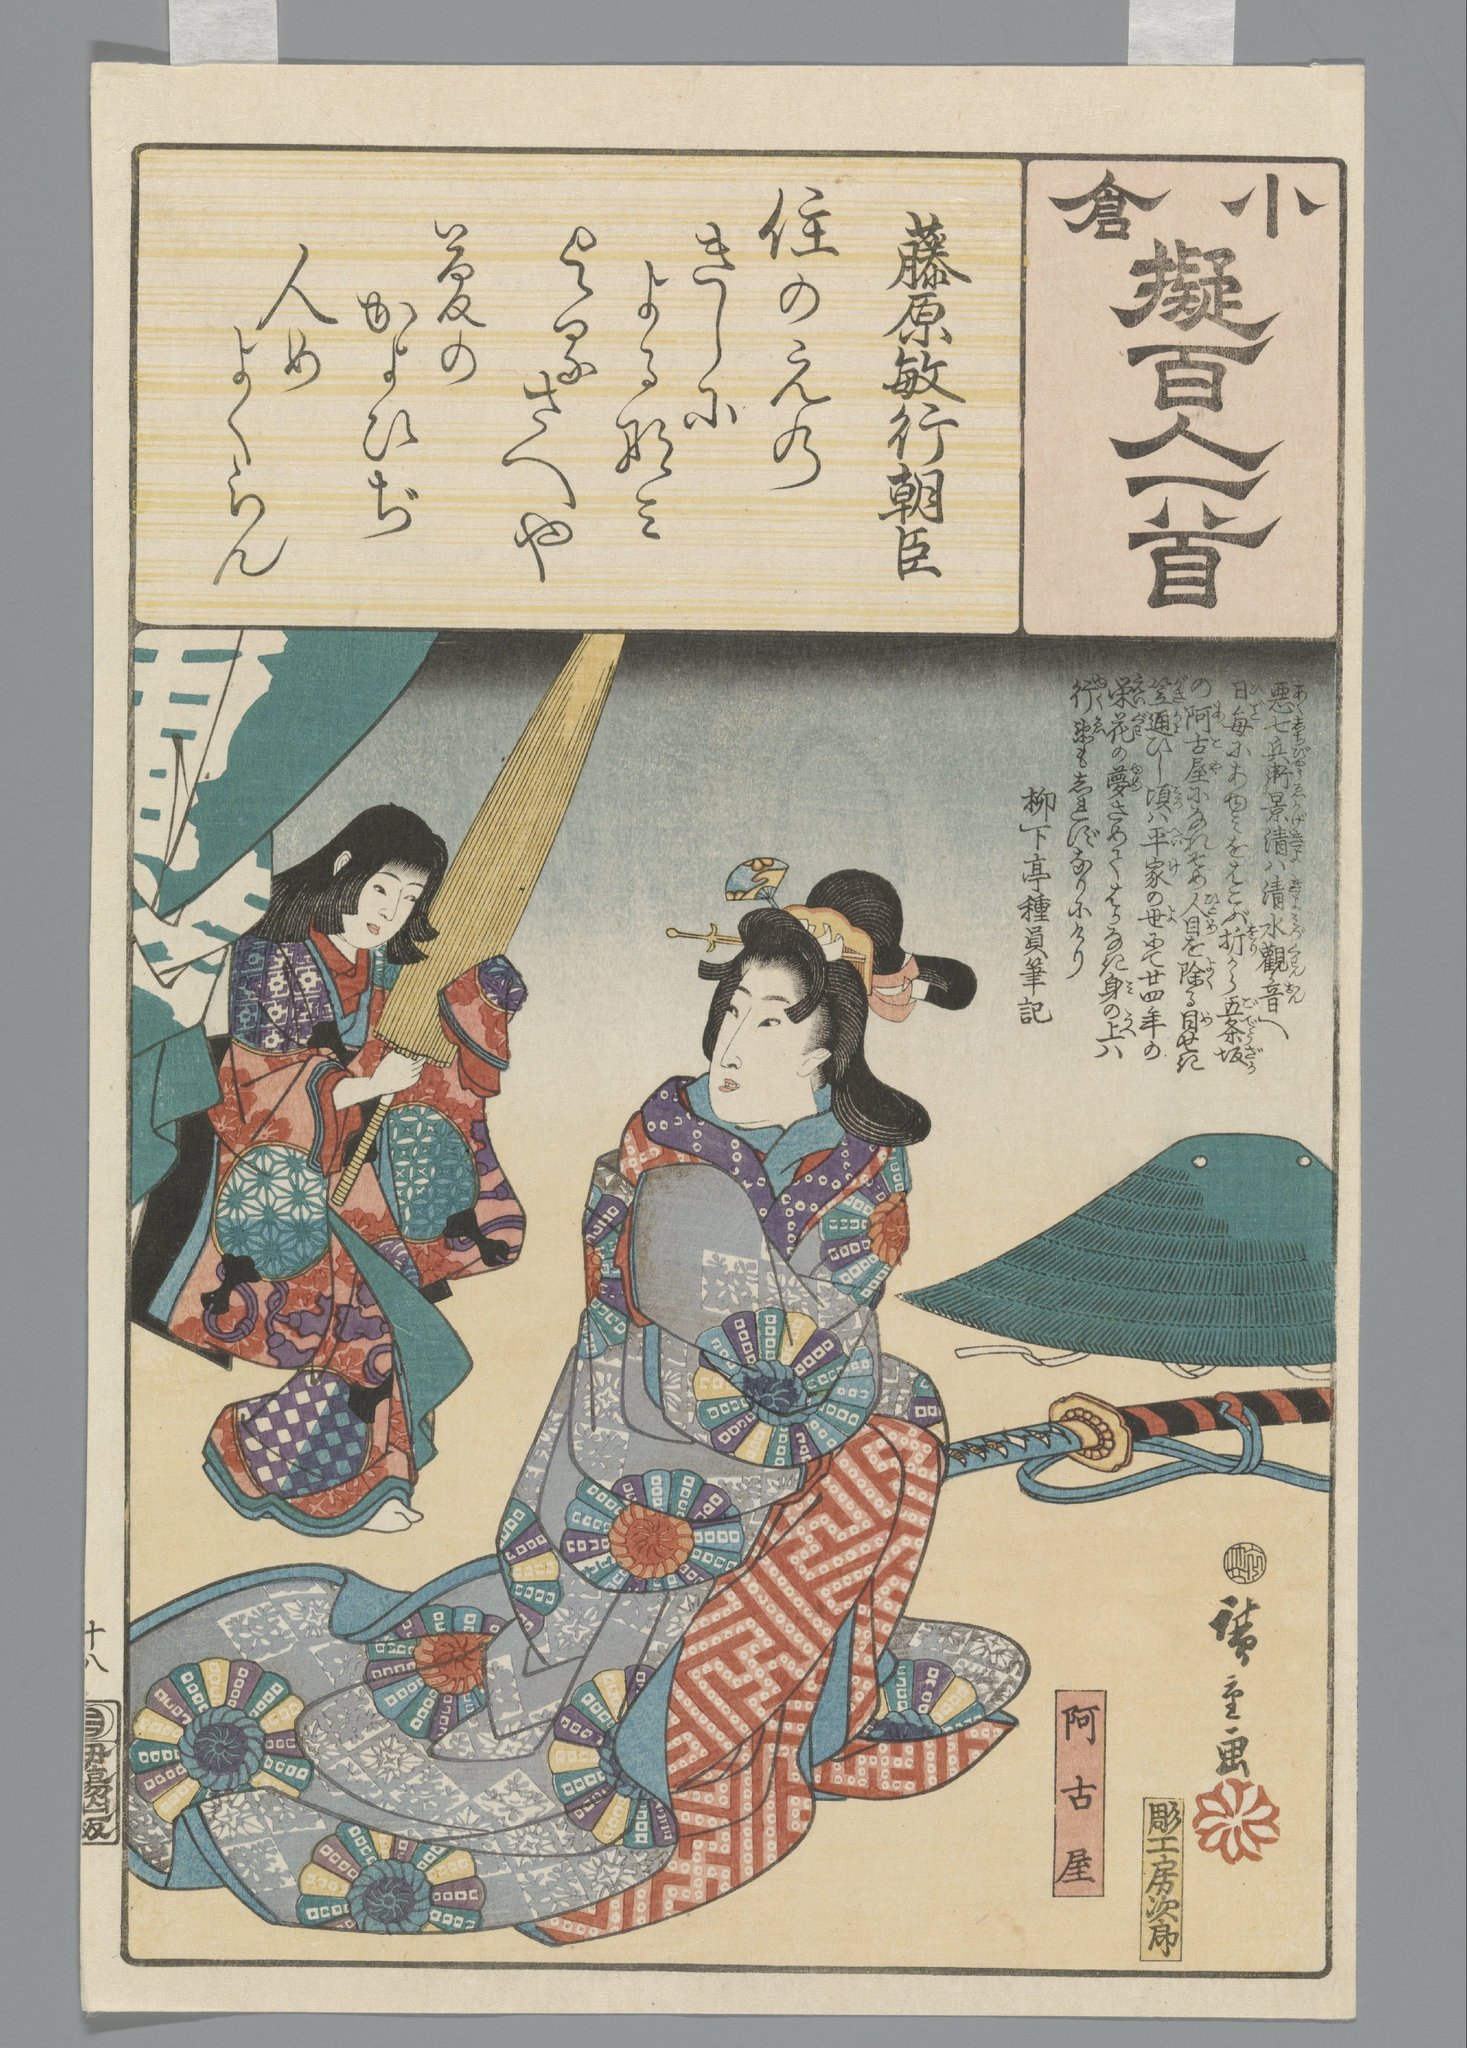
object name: print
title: Ogura Imitation of the One Hundred Poems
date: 1845-1846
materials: paper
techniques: woodcut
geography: japan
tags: courtesan, hetaera, maid ~ house personnel, parasol, sunshade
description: Courtisane Akoya kijkt om naar haar hulp met parasol. Op de achtergrond een zwaard en hoed, verwijzend naar haar geliefde, generaal Kagekiyo. Scene uit een kabukitoneelstuk. Gedicht door Fujiwara no Toshiyuki Ason.